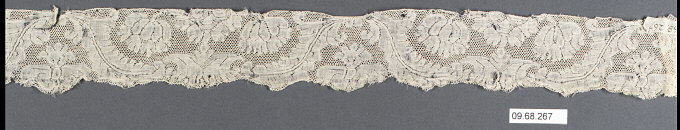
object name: border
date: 1734-1766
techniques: lace